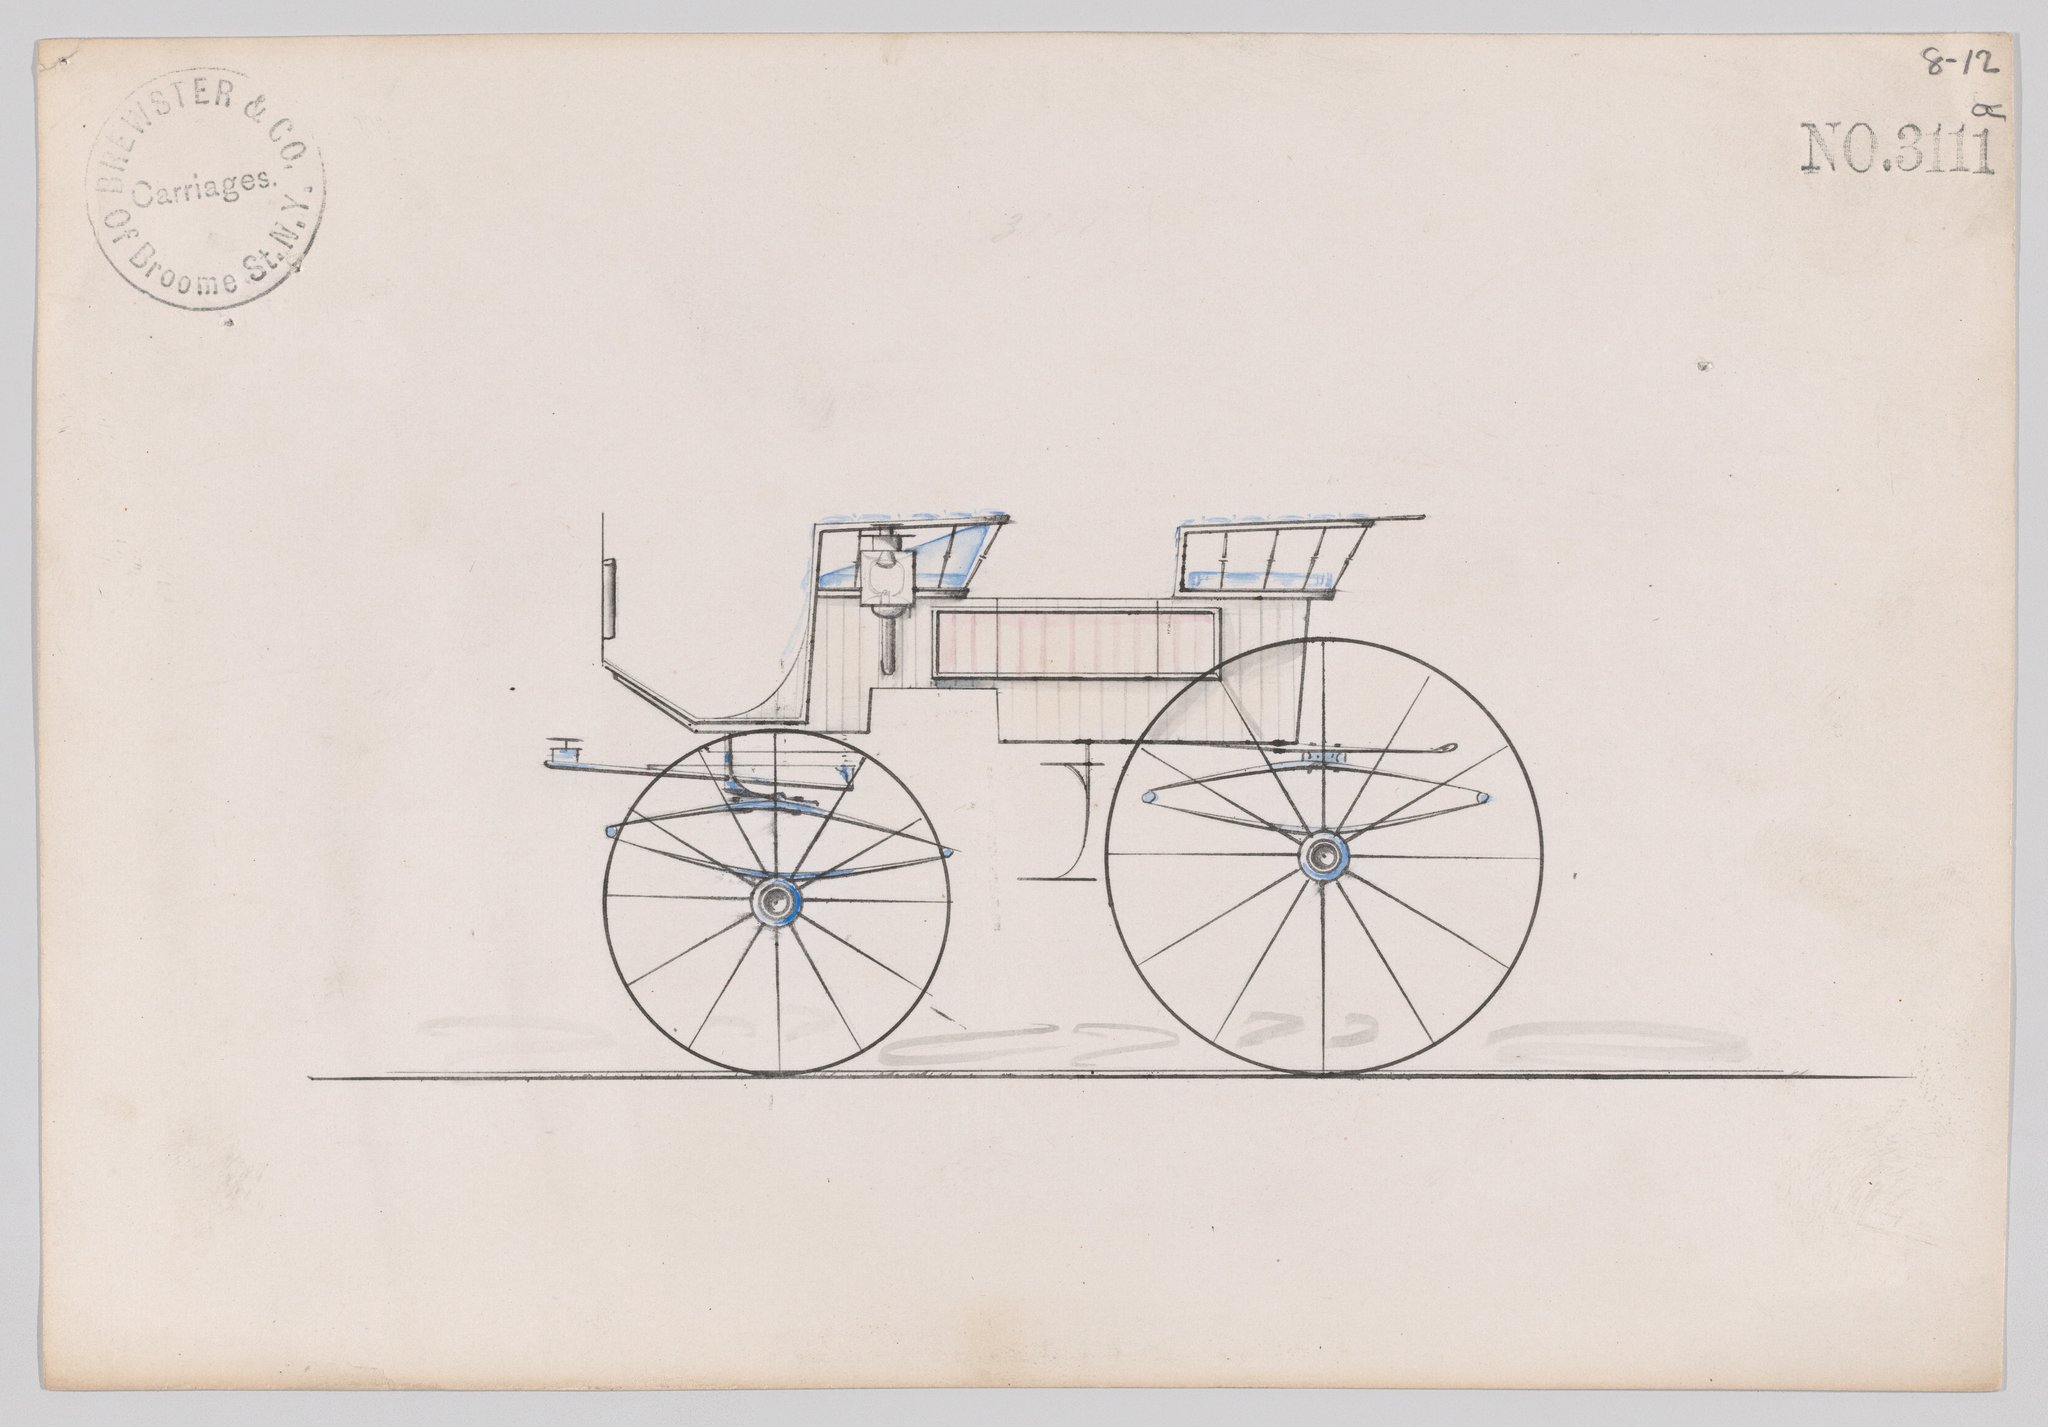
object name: drawing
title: Design for 4 seat Phaeton, no top, no. 3111a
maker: brewster & co.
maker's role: manufacturer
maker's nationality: american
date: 1875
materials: gouache, ink, watercolor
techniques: pen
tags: carriages